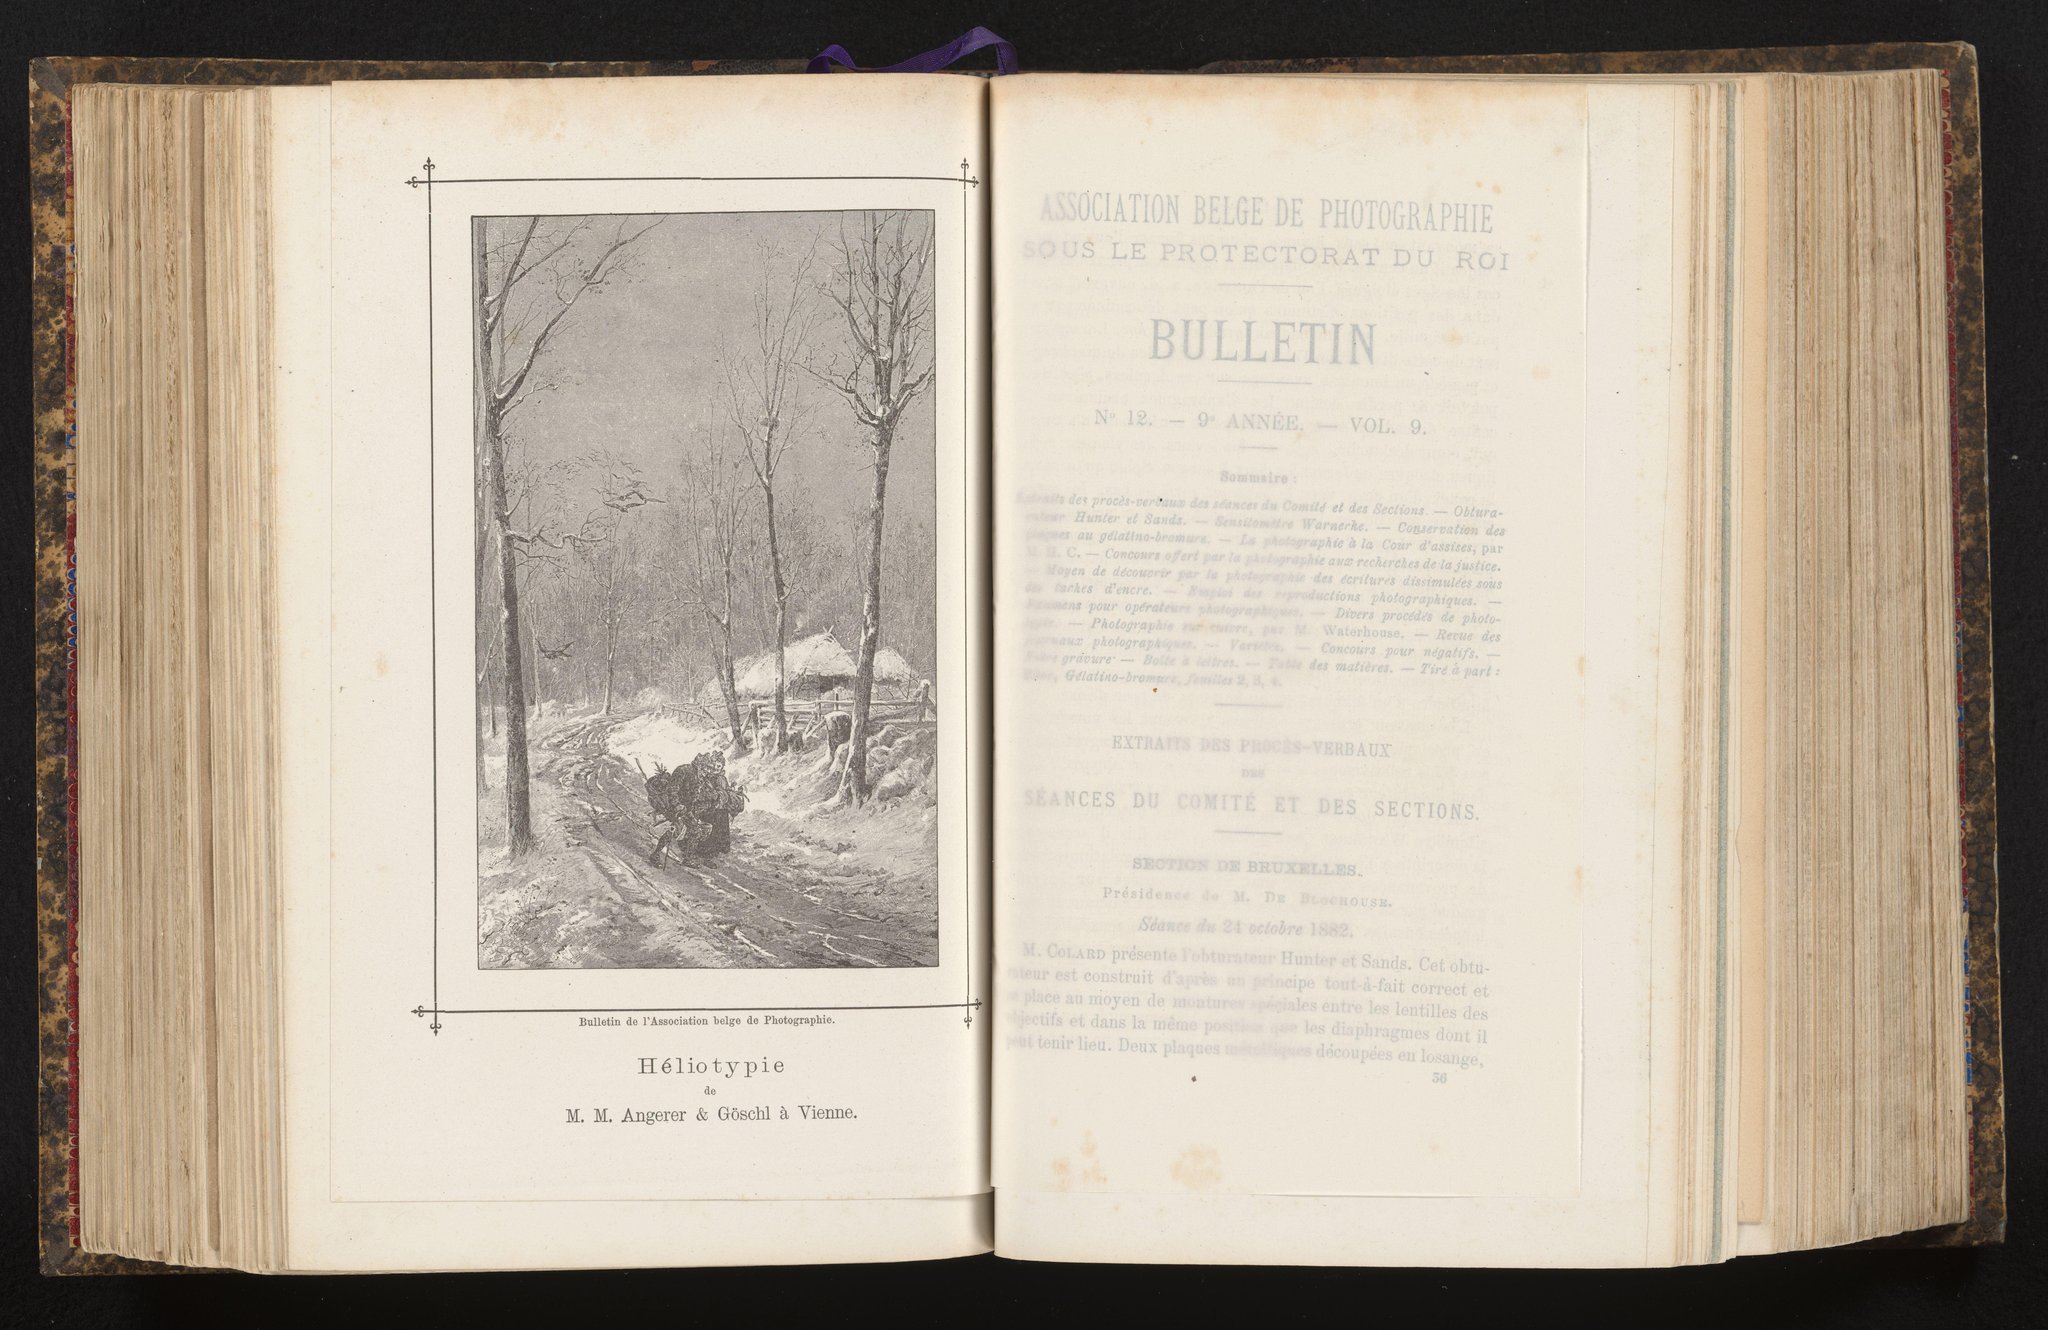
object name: photomechanical print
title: Reproductie van een ontwerp met de voorstelling van twee onbekende personen die over een besneeuwd pad wandelen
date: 1878-1883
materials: paper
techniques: autotype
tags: historical persons, snow, painting, drawing and the graphic arts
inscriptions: inscription: ‘Bulletin de l'Association belge de Photographie’